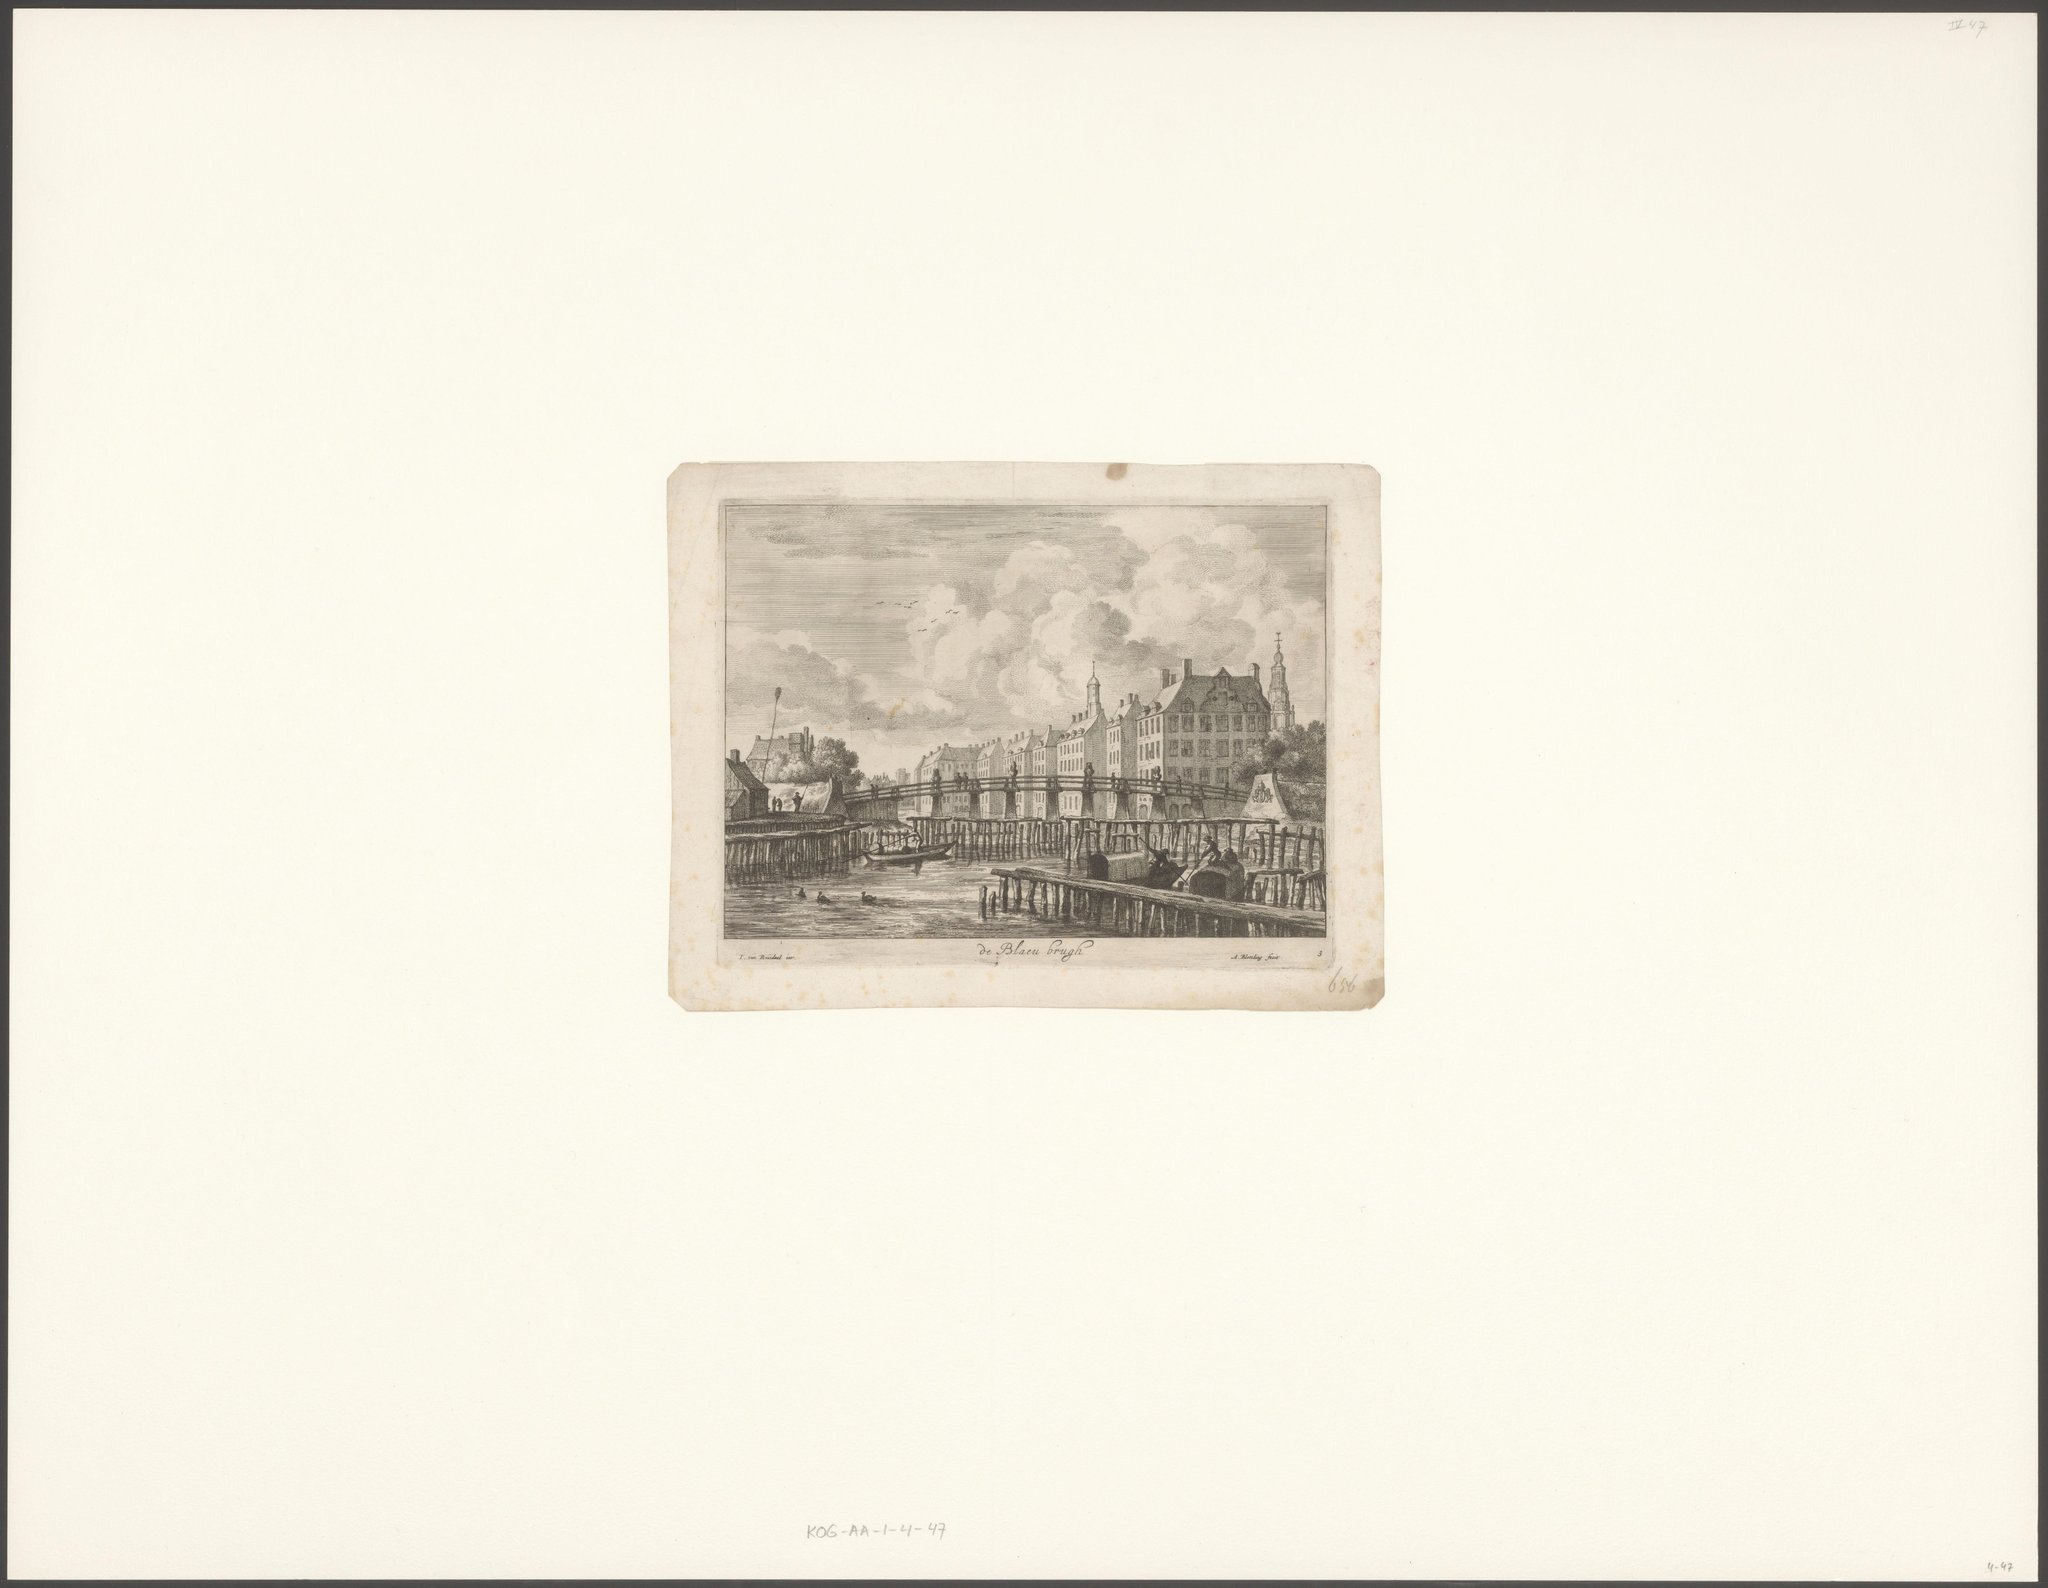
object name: print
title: Gezicht op de Blauwbrug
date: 1650-1690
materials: paper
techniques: etching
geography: amsterdam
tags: city-view in general; 'veduta', canal, bridge in city across river, canal, etc., boat propelled by man or animal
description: Onderwerpsrubriek binnen de Atlas Amsterdam: Amstel van Blauwbrug tot Hogesluis.